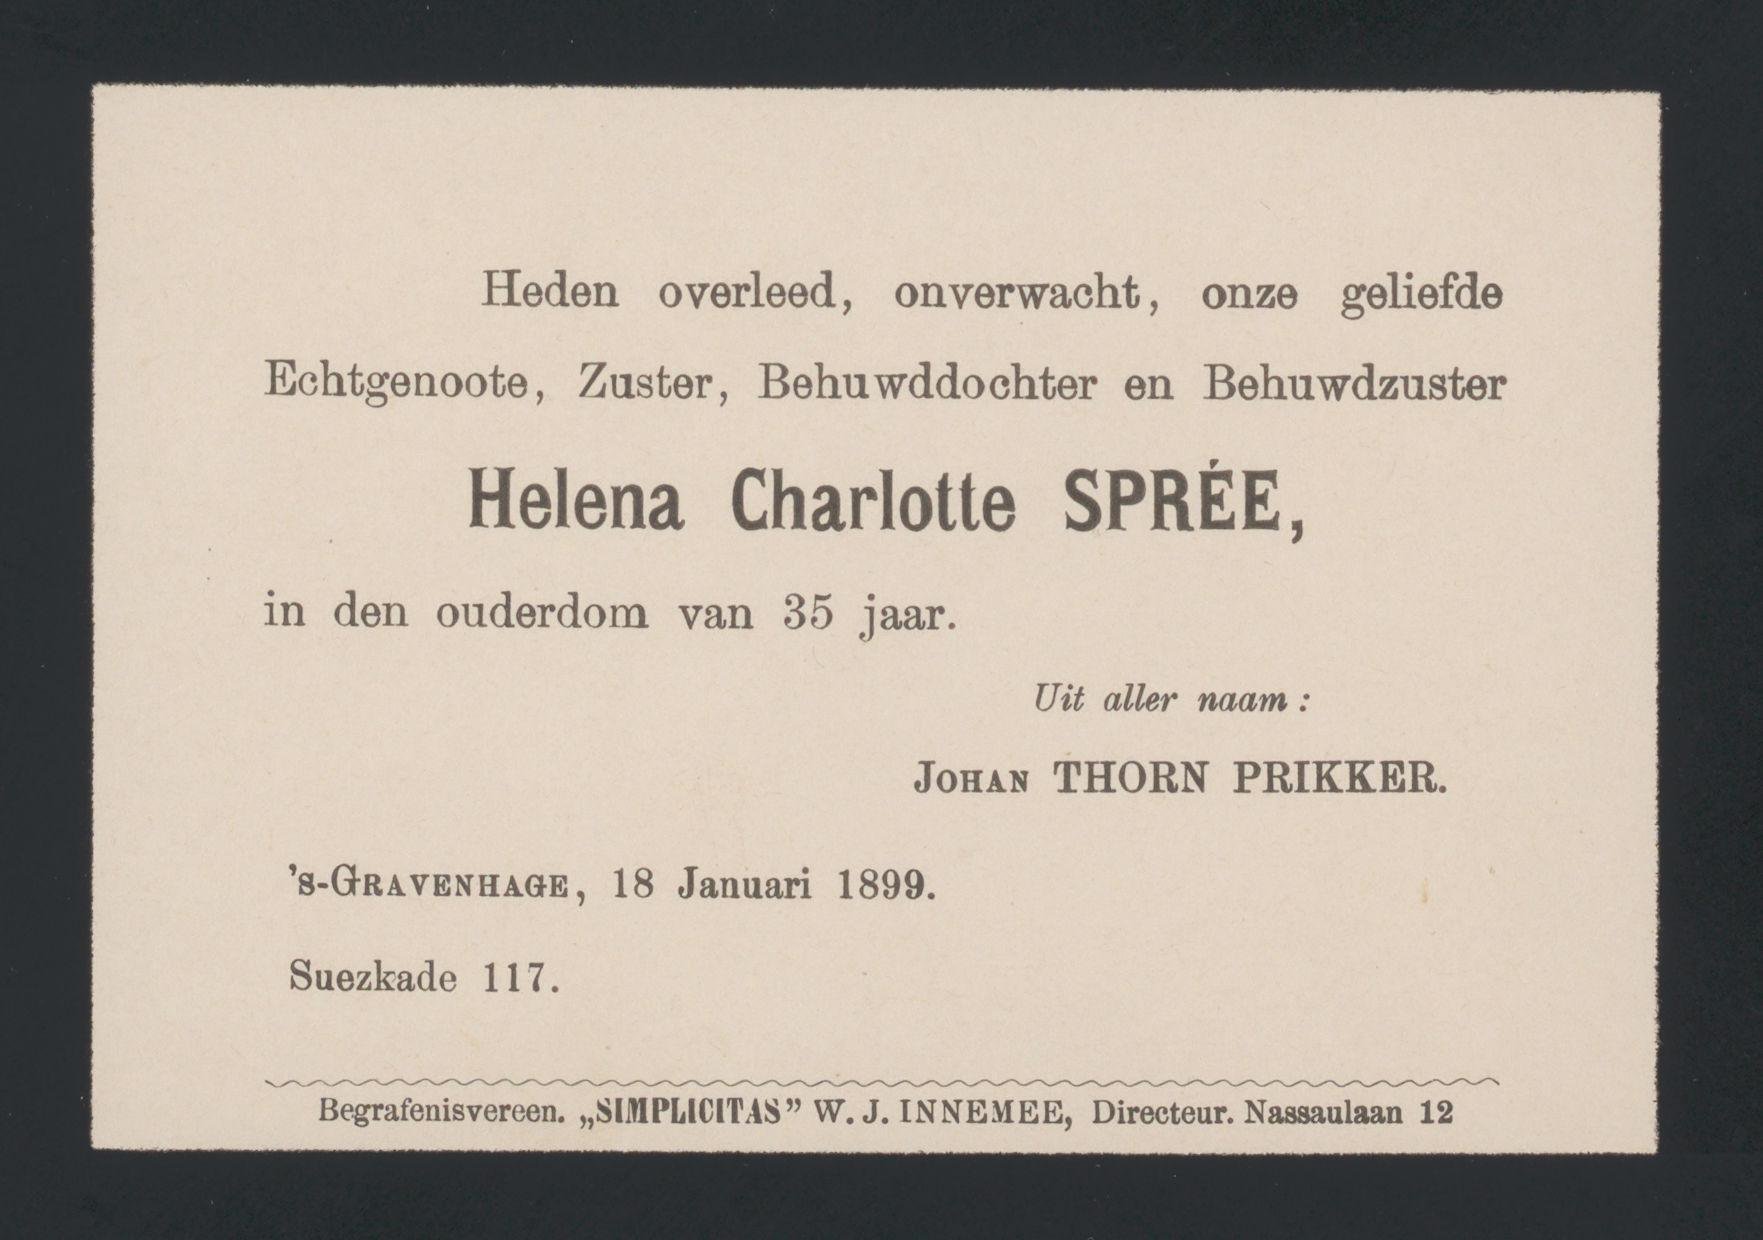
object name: overlijdensbericht, overlijdensadvertentie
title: Overlijdensbericht aan Philip Zilcken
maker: Anonymous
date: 1899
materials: cardboard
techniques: printing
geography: the hague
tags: painter, draughtsman, philip zilcken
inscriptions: collector's mark: ‘RPK’